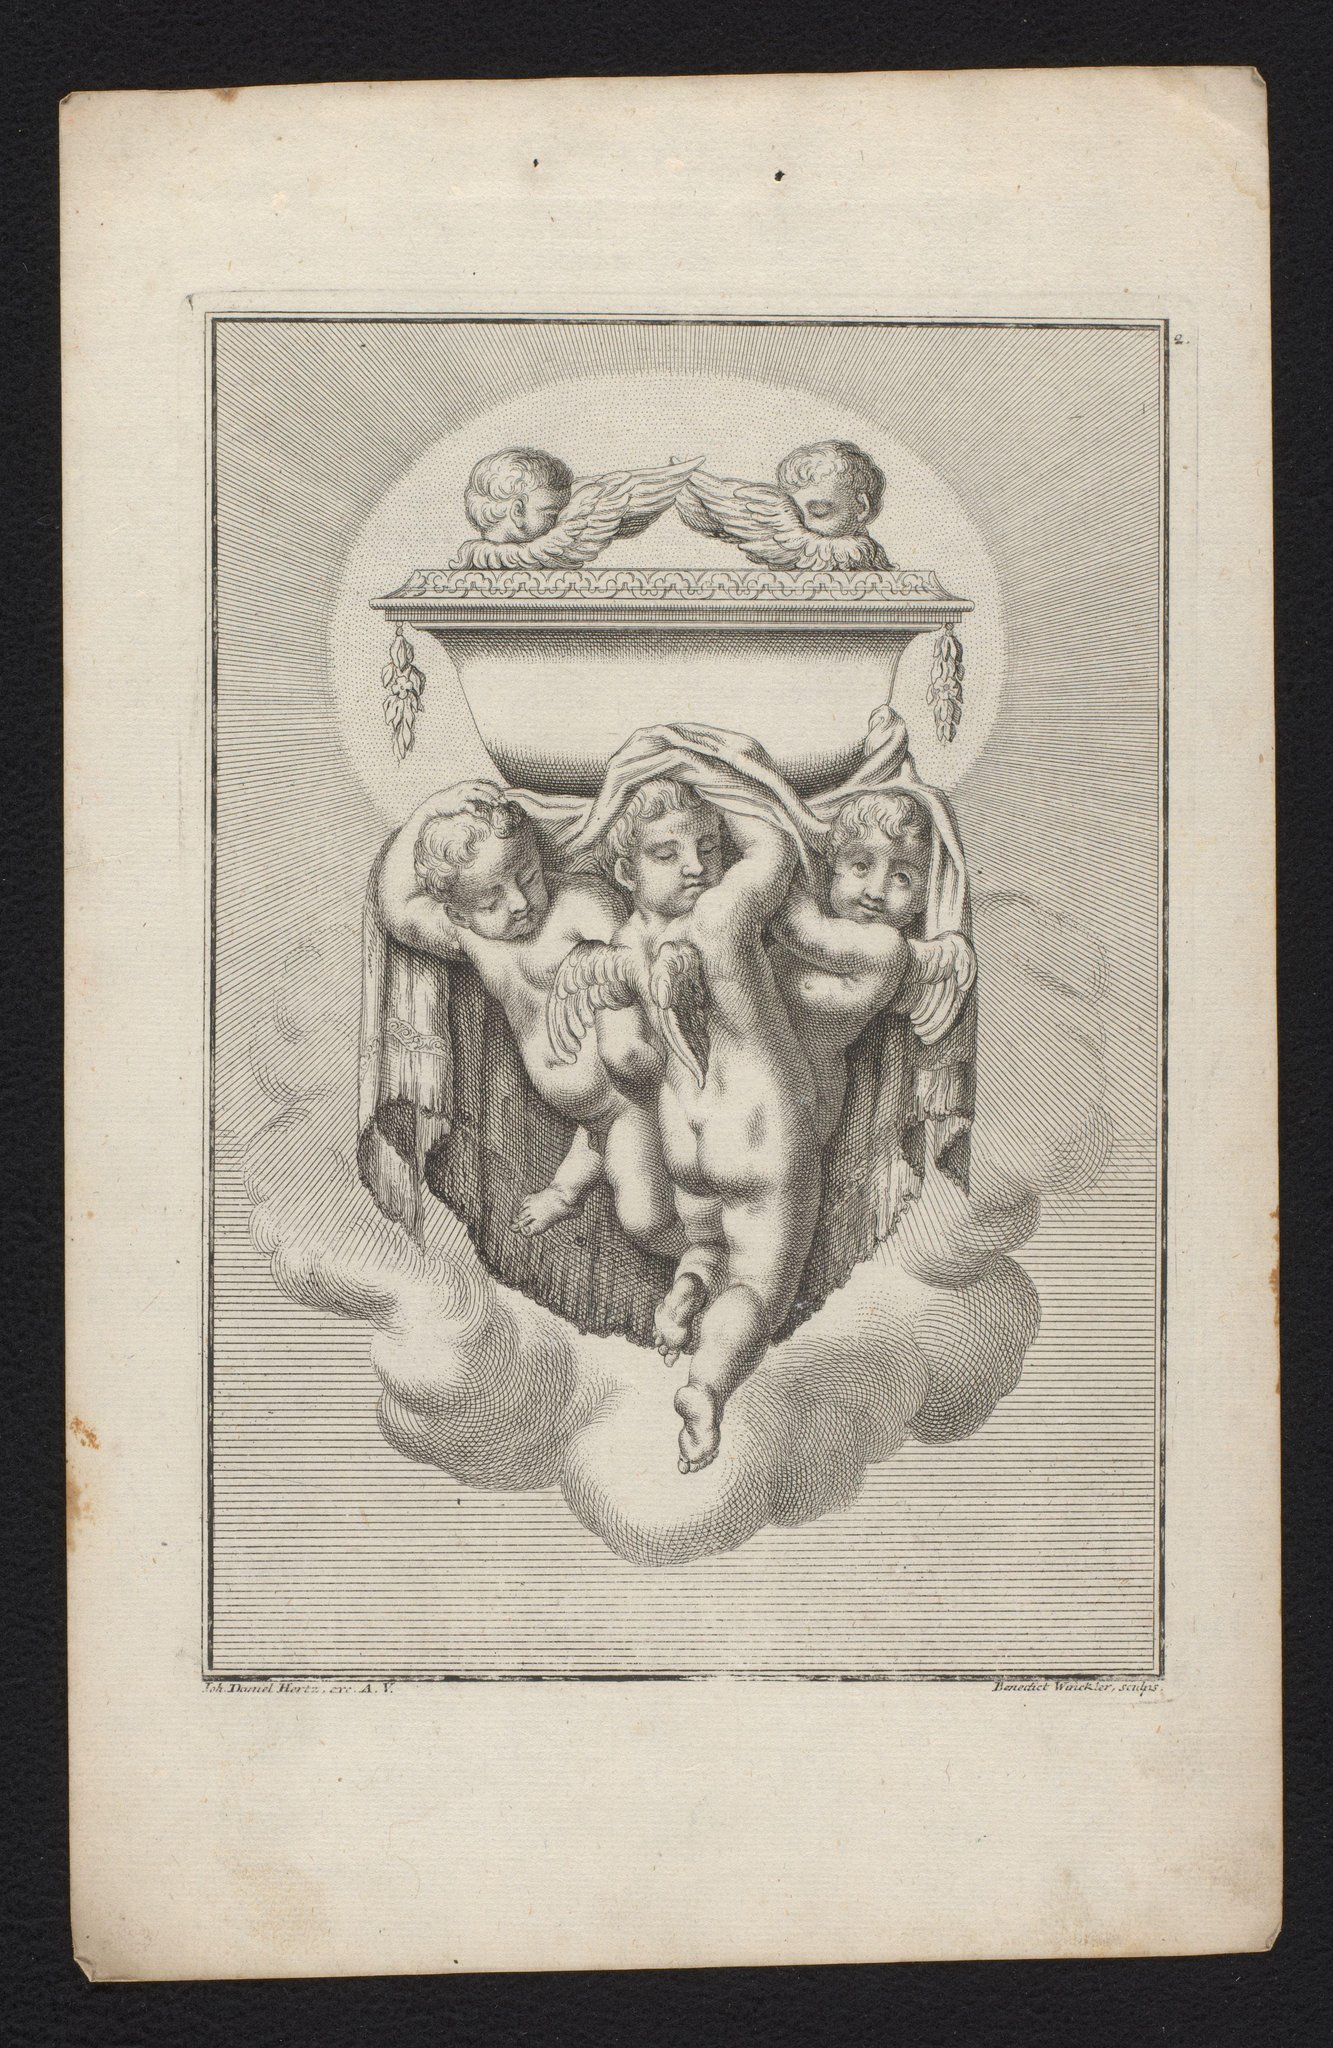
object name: ornament print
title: Drie putti dragen een vaas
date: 1737-1754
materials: paper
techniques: engraving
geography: augsburg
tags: vase ~ ornament, cupids: 'amores', 'amoretti', 'putti'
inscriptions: collector's mark: Lugt 2228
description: Drie putti met een doek dragen een vaas of urn. Op de vaas twee gevleugelde puttihoofden.